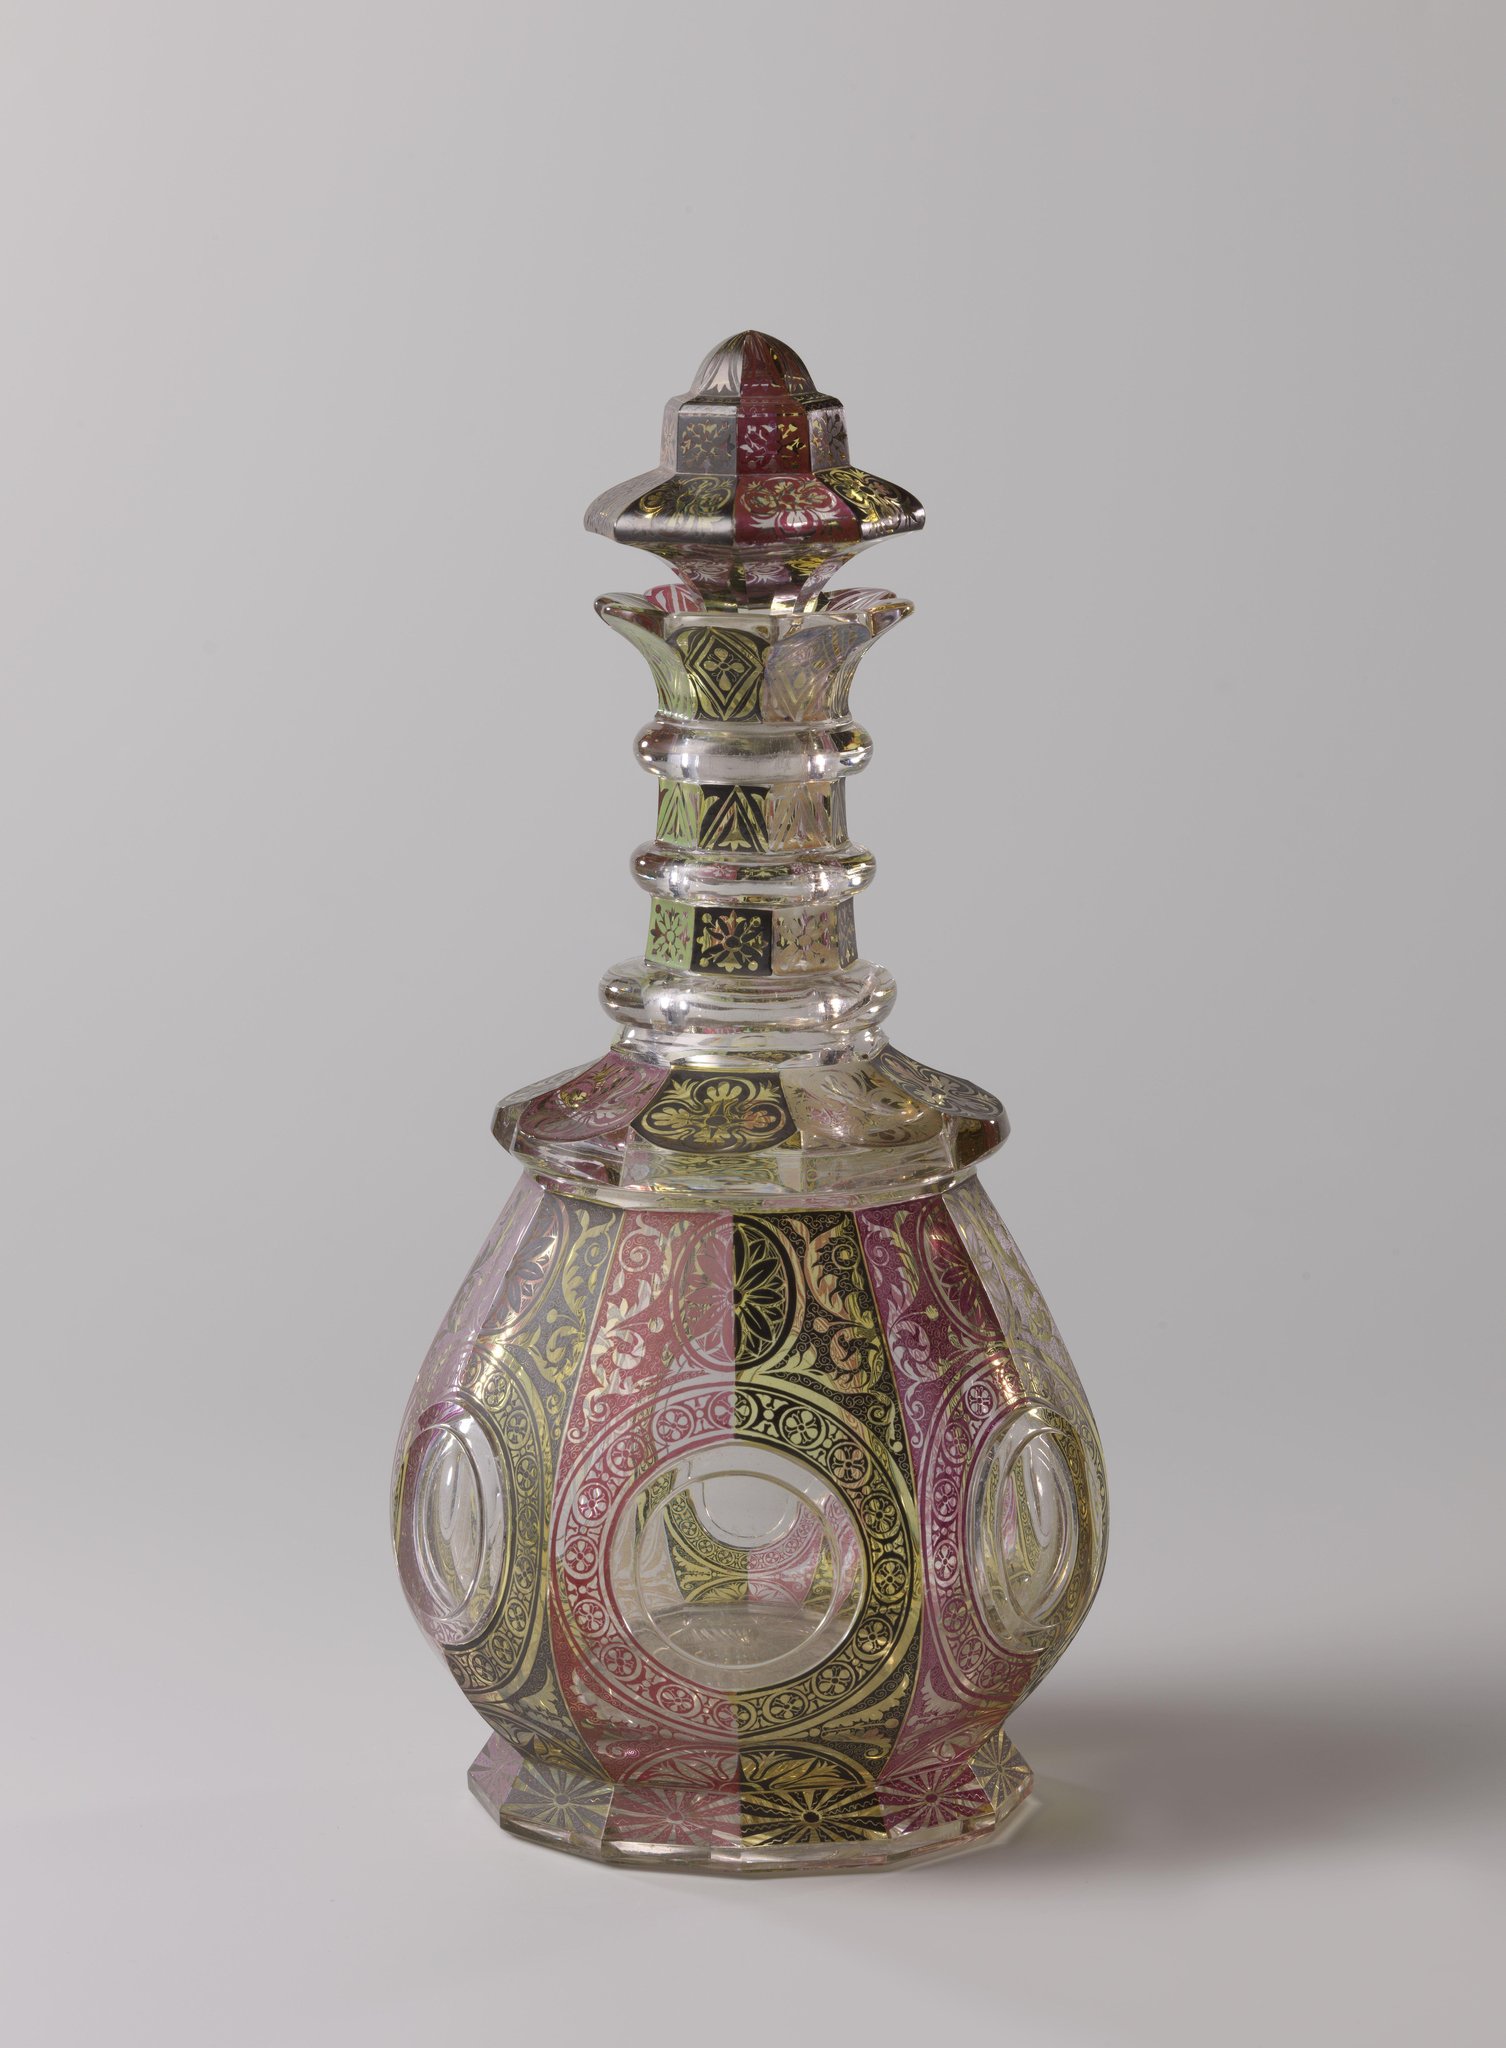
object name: carafe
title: Karaf met neorenaissancistische en neogotische ornamenten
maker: Anonymous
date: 1850-1900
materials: glass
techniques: glassblowing, grinding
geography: europe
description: Platte bodem en conische, gefacetteerde voet. Peervormig, gefacetteerd lichaam met een uitkragende, brede, gelobde rand, overgaande in een cilindervormige, gefacetteerde hals met drie ringen en een uitgebogen mond.Op het lichaam zes lege medaillons, omgeven door neorenaissancistische en neogotische banden en rankwerk.